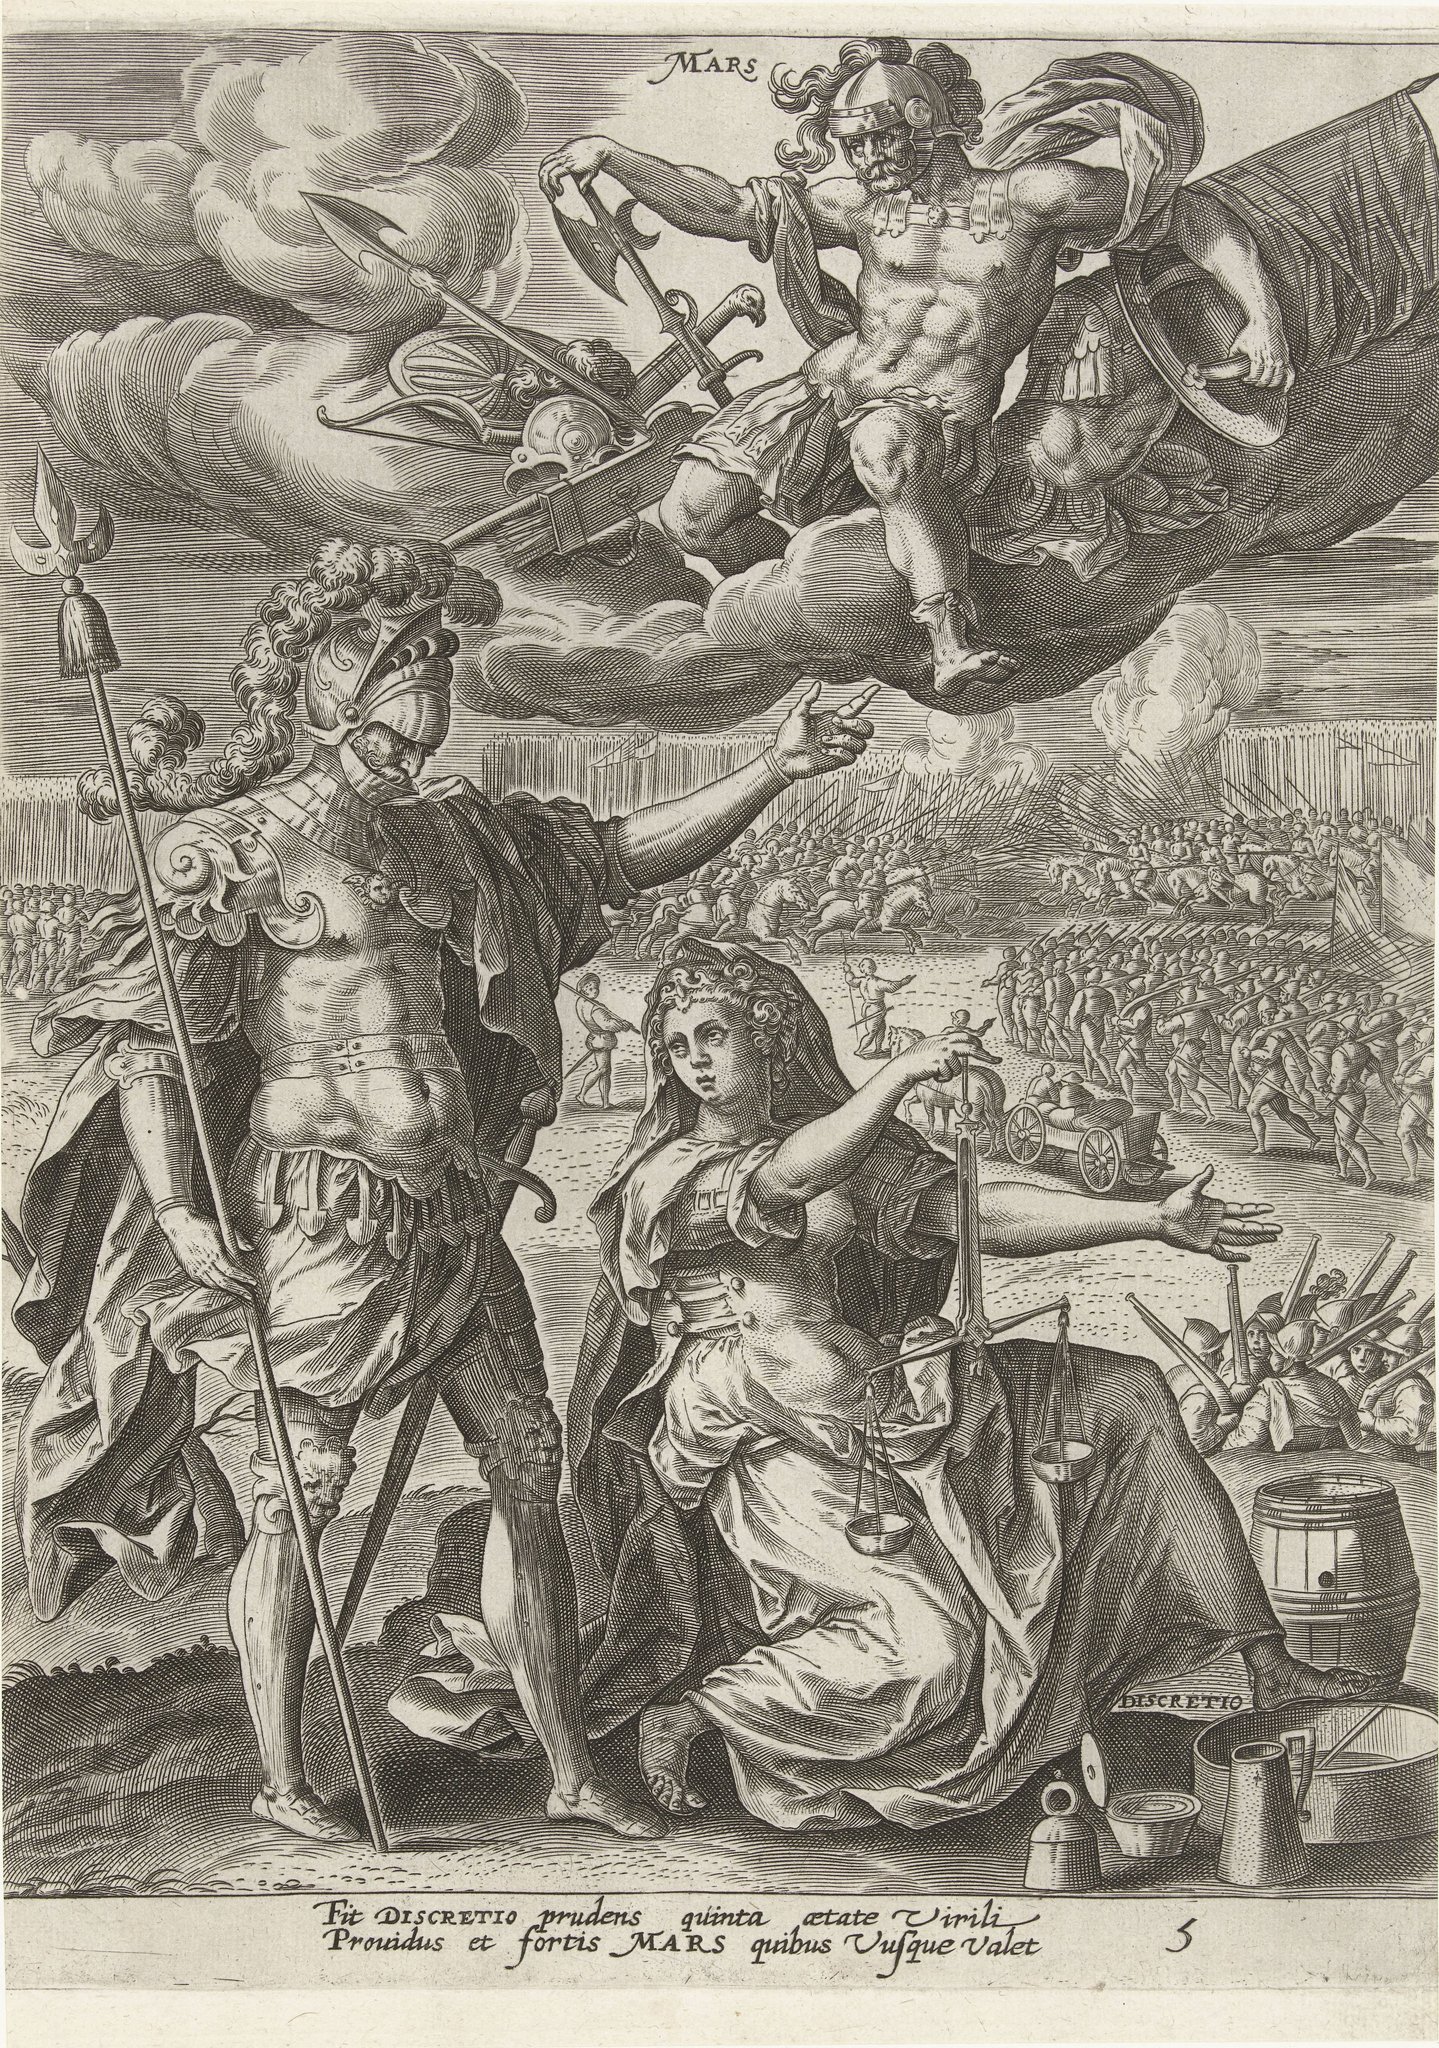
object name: print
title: Septem planetae, septem hominis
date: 1581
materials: paper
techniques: engraving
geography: antwerp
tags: adult man, battle, discretion, modesty; 'discretione', 'modestia' (ripa), mars and his children ('planetenkinder')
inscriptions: collector's mark: Lugt 2228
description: In de lucht zweeft de planeetgod Mars, omringd door allerlei wapentuig. Op de voorgrond de personificatie van Discretio, onderscheid. Ze heeft als attributen de weegschaal, de maatbeker en de zeef. Naast haar staat een soldaat met een lans. Op de achtergrond een veldslag. De prent heeft een Latijns onderschrift en is deel van een zevendelige serie over de macht van de zeven planeten over de zeven leeftijden van de mens.